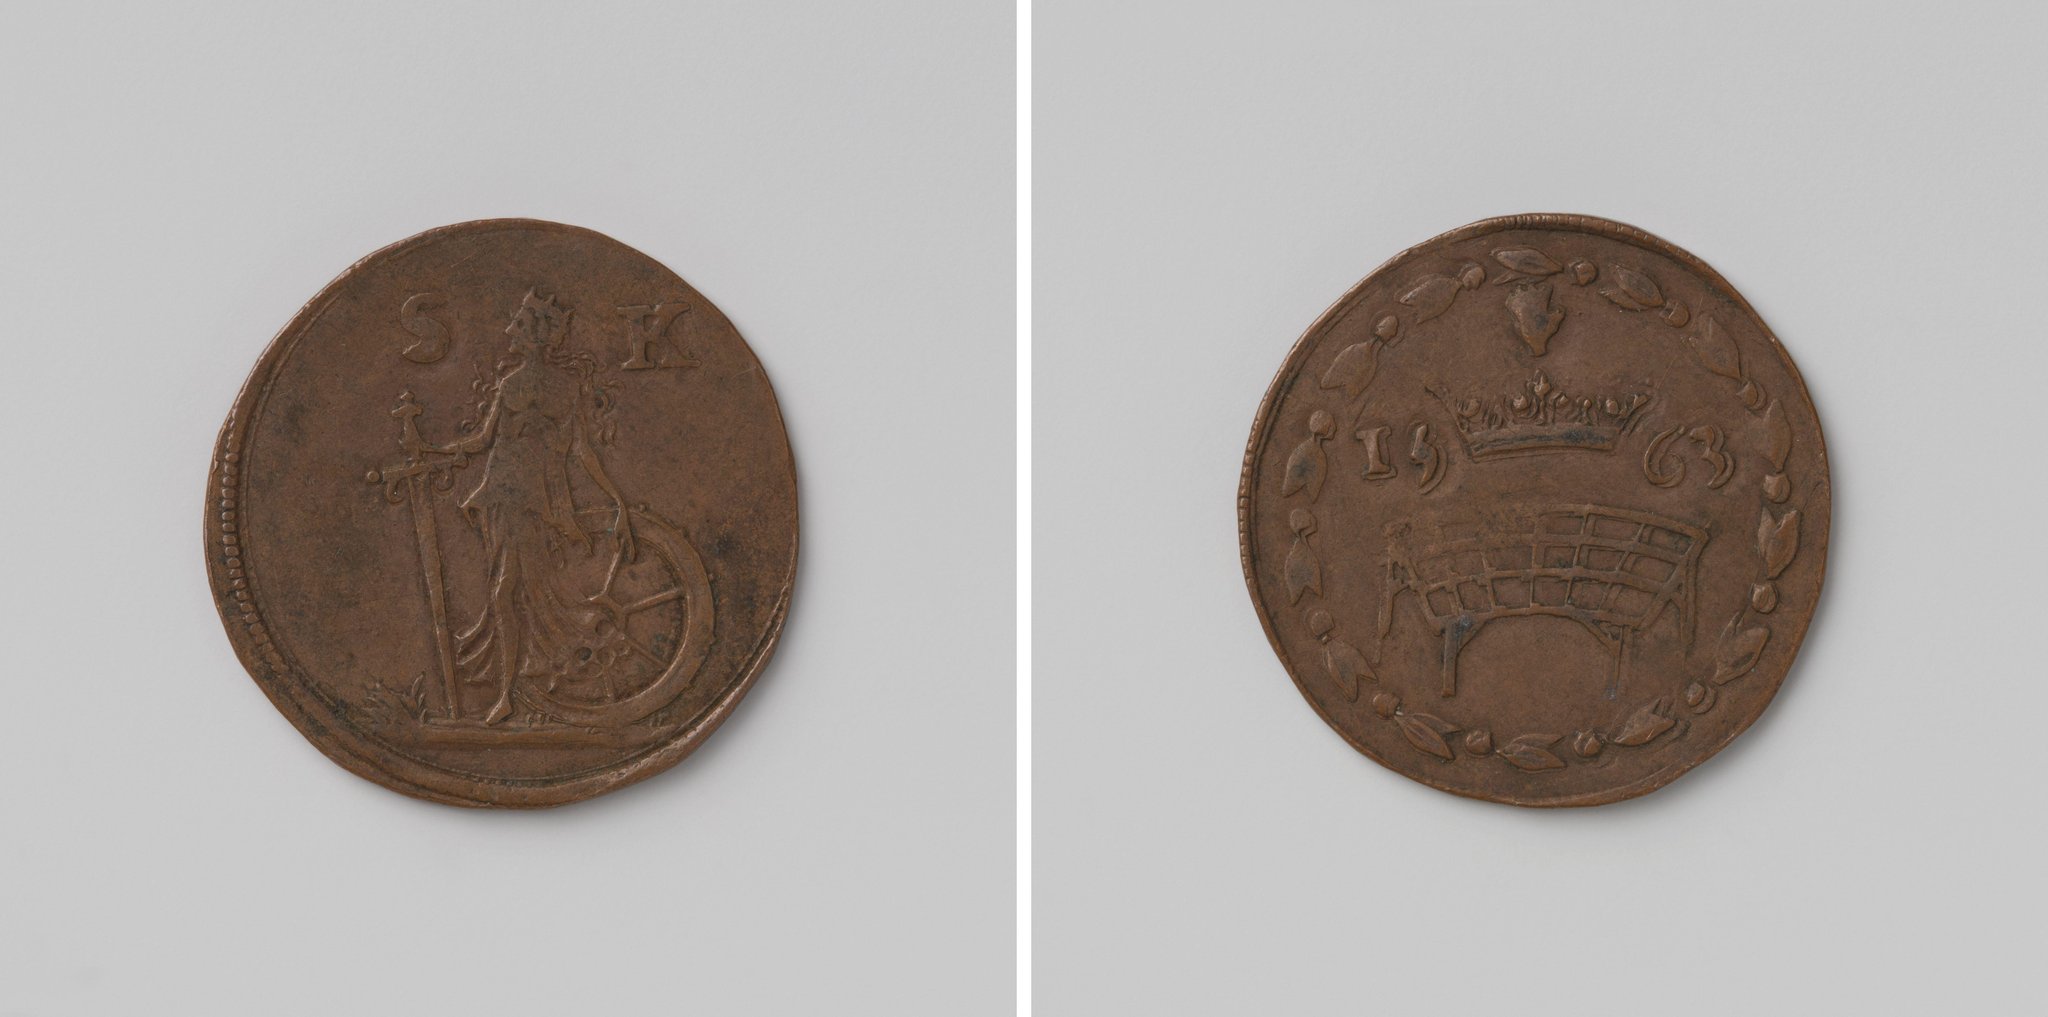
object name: medal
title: Broekenmakersgilde van Antwerpen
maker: Anonymous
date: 1563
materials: copper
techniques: striking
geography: antwerp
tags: antwerp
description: Koperen penning. Voorzijde: vrouw, voorstellende St. Catherina, staande tussen letters S en K houdt zwaard met punt op grond in rechter- en rad in linkerhand. Keerzijde: bed of tafel onder kroon tussen jaartal en geopende hand binnen bladerkrans.